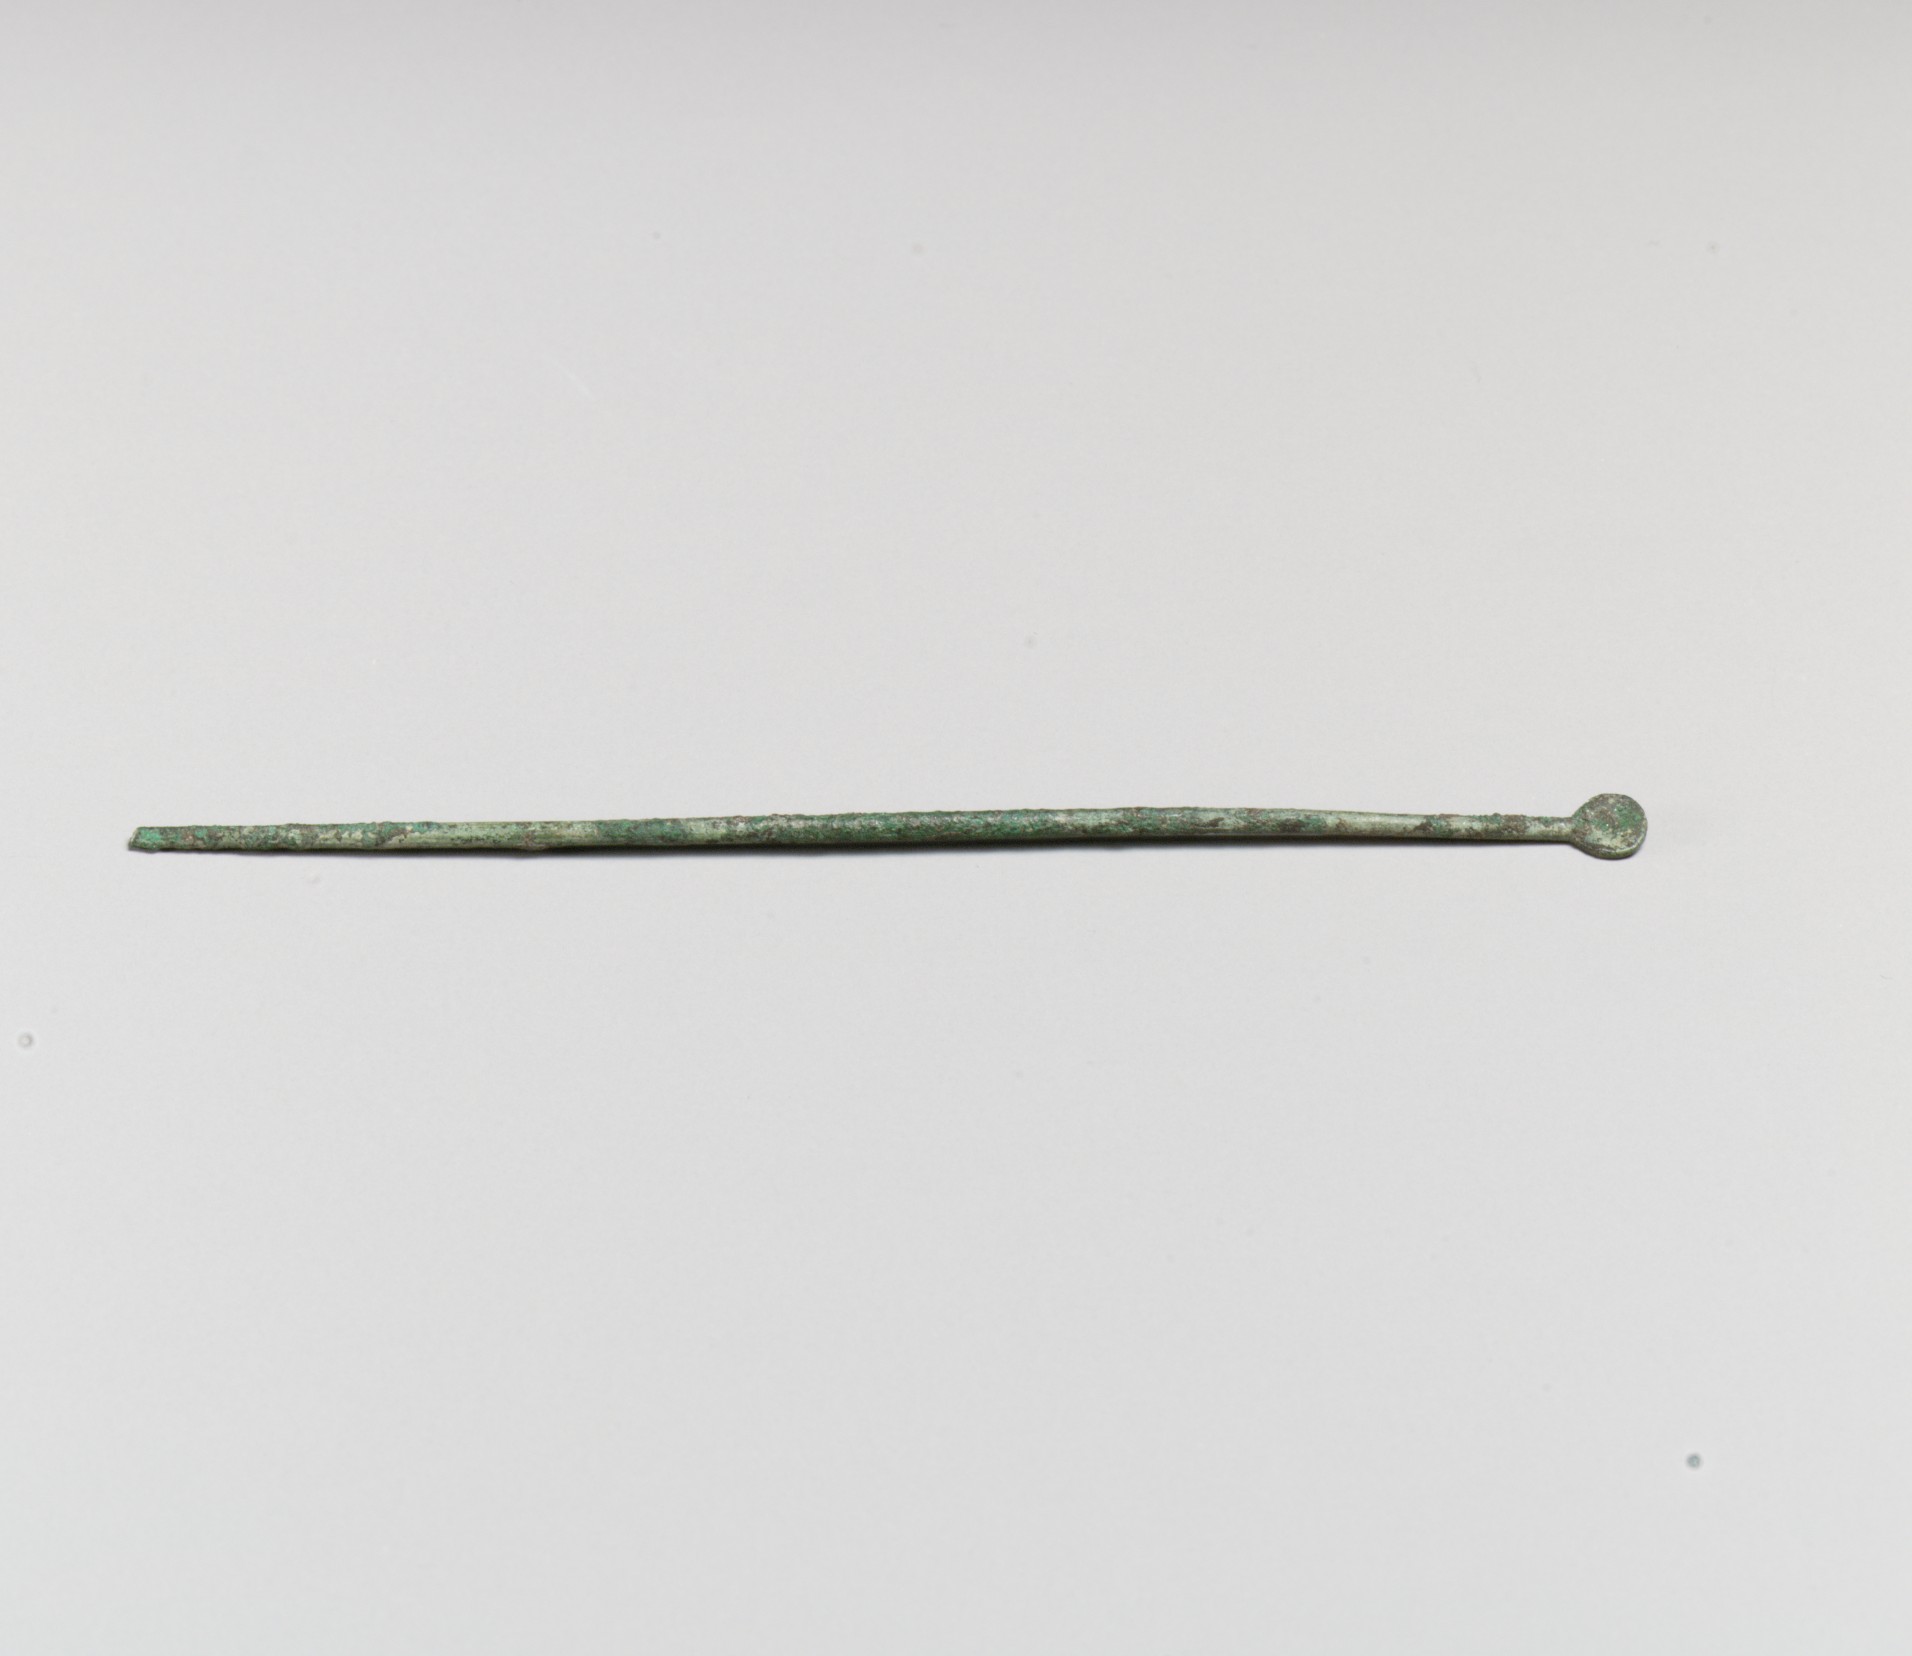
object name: spoon or ligula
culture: roman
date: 670 BCE-330 CE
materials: bronze